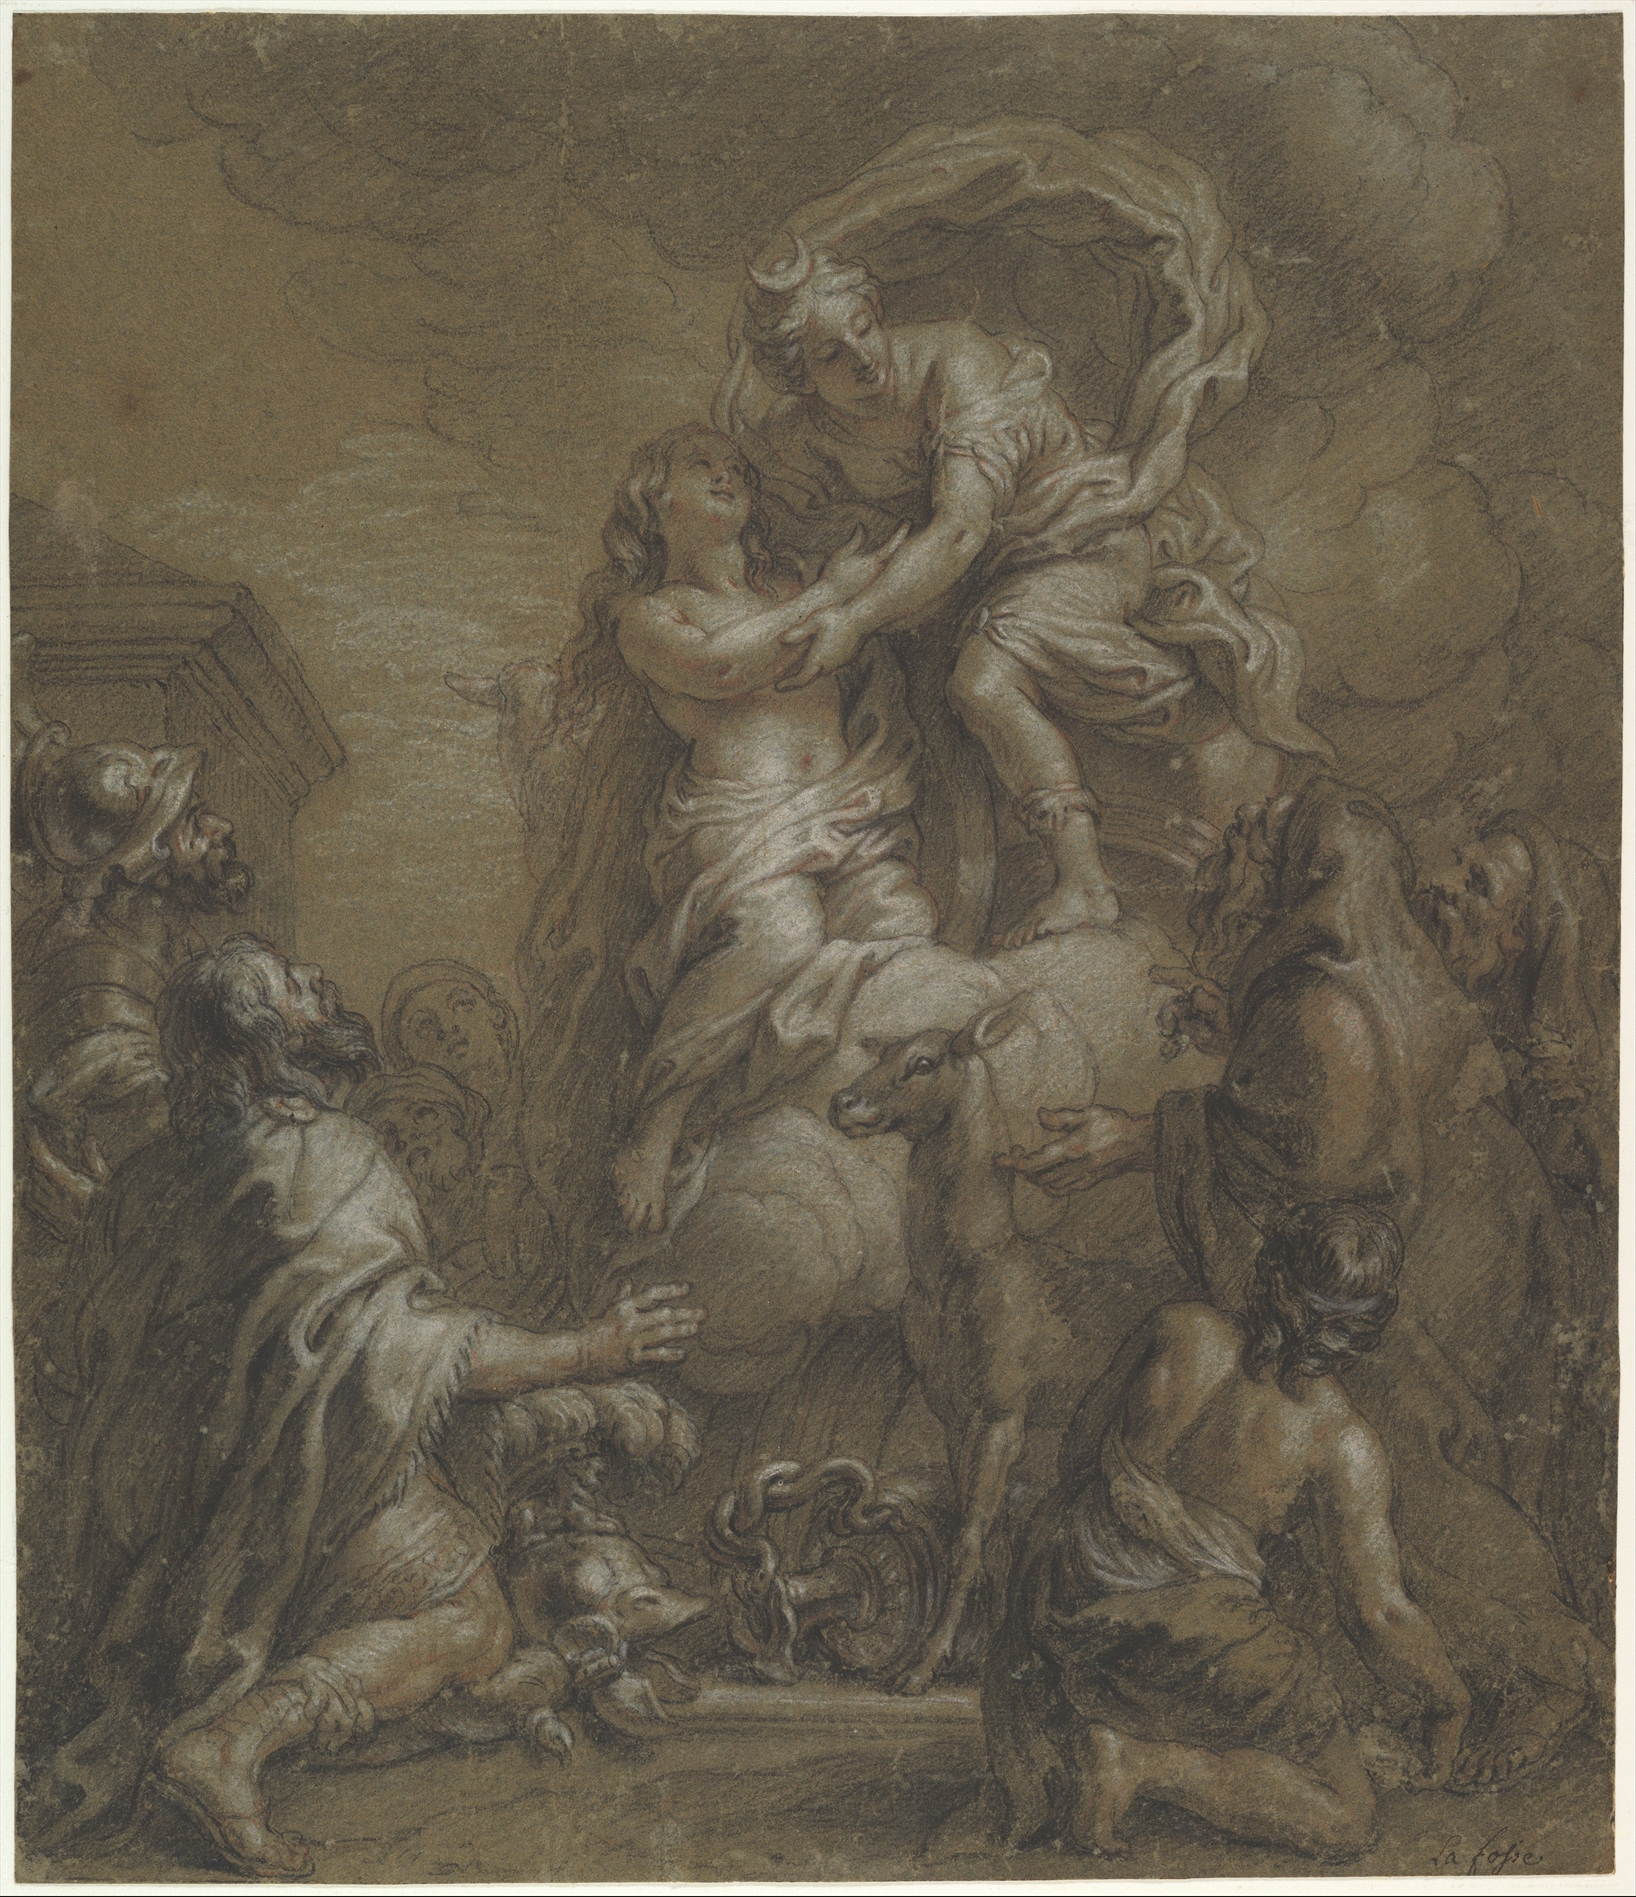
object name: drawing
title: Sacrifice of Iphigenia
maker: charles de la fosse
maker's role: artist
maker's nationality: french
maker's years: 1636-1716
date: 1678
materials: chalk, paper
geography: france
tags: animals,men,iphigenia,goddess